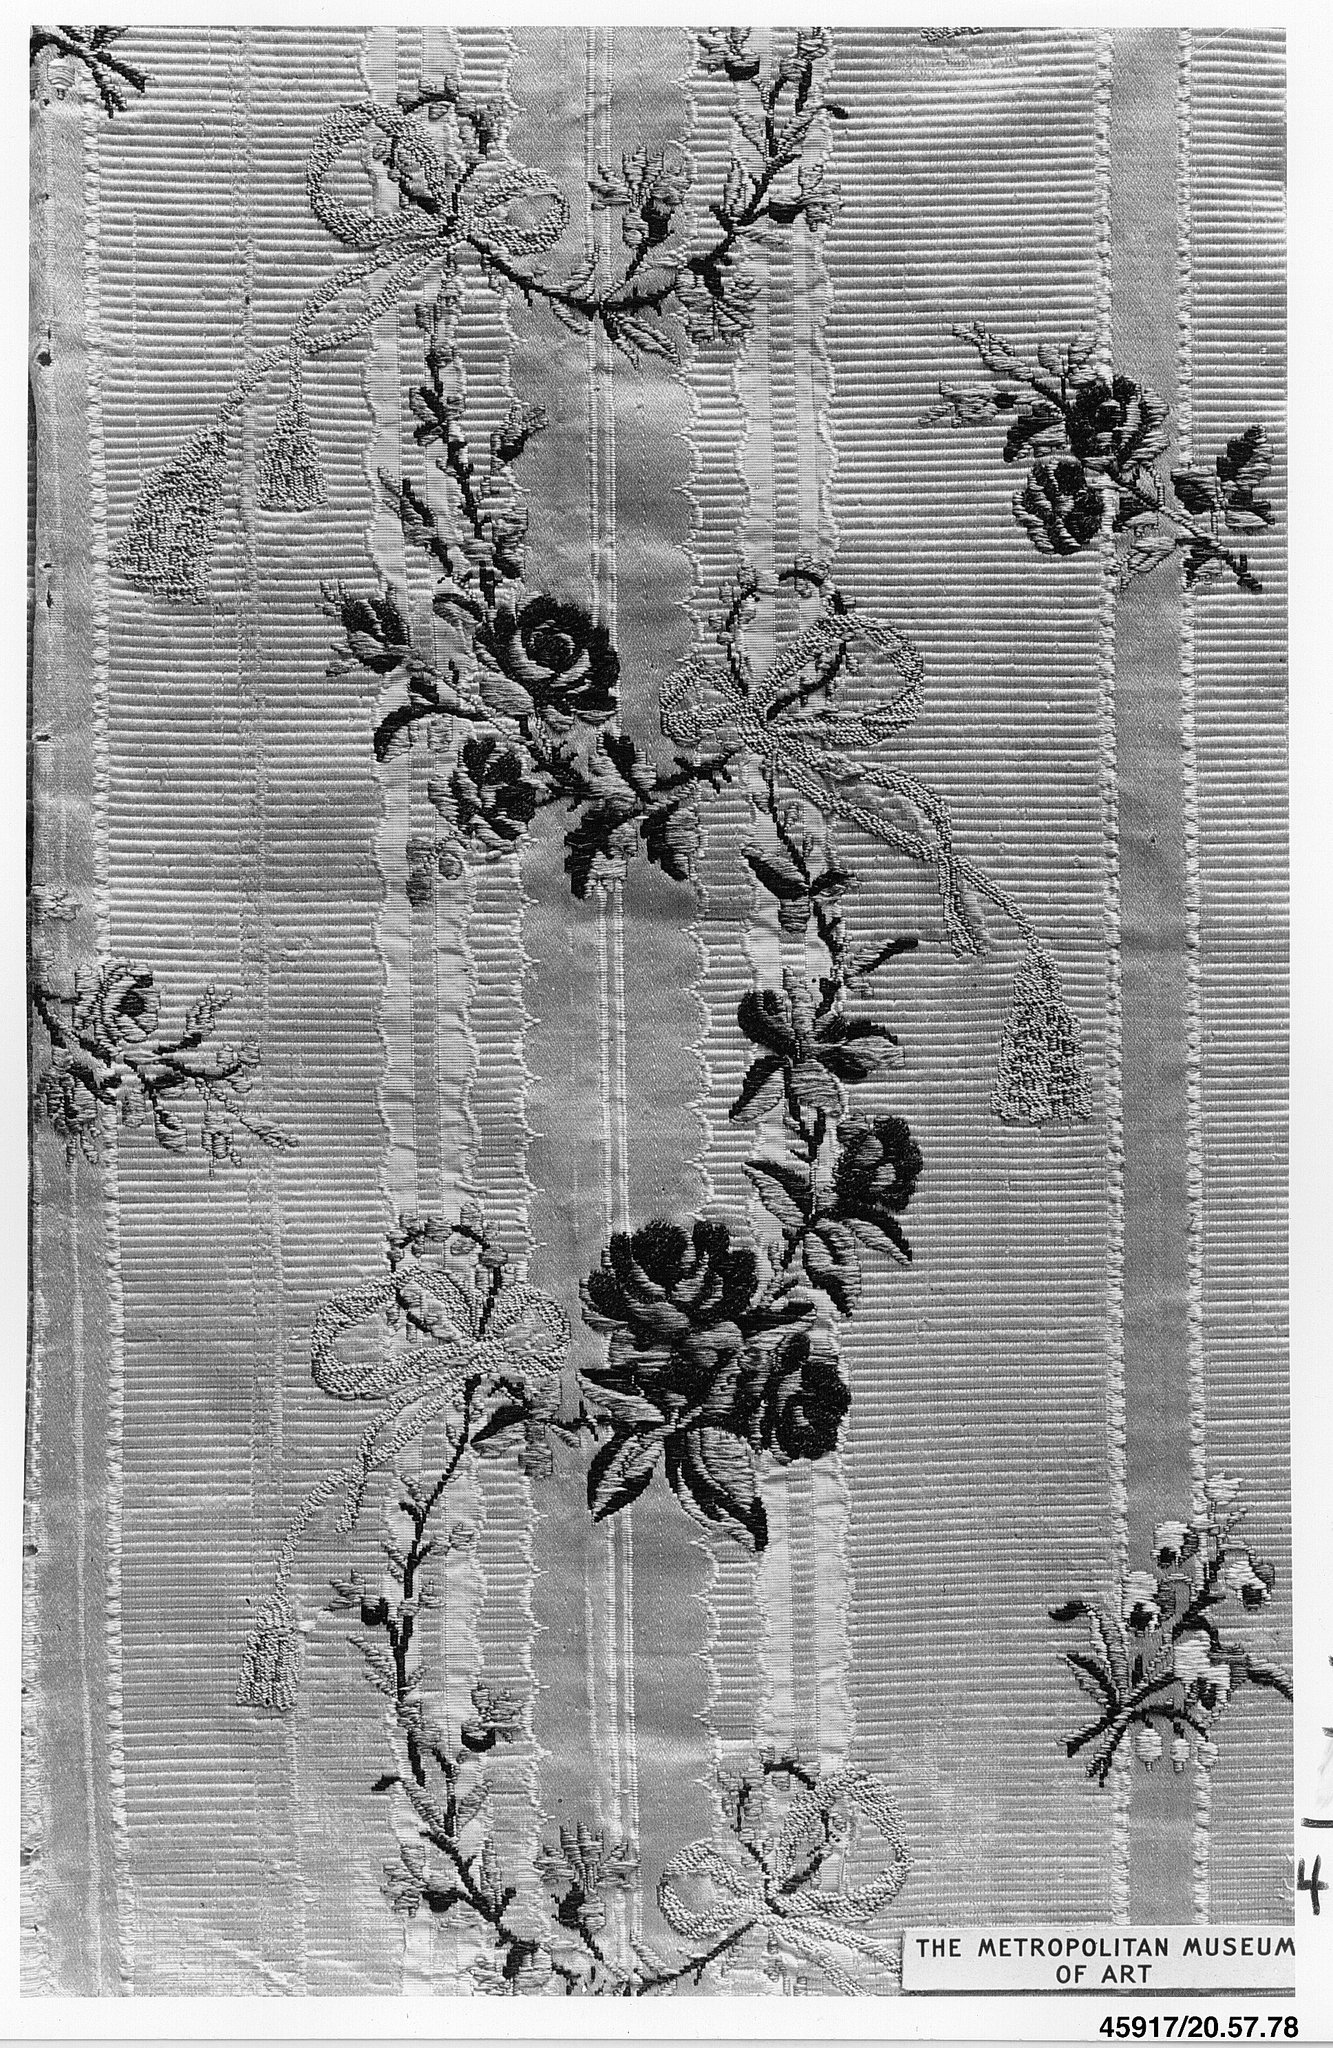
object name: piece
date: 1775-1792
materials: silk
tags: flowers,leaves